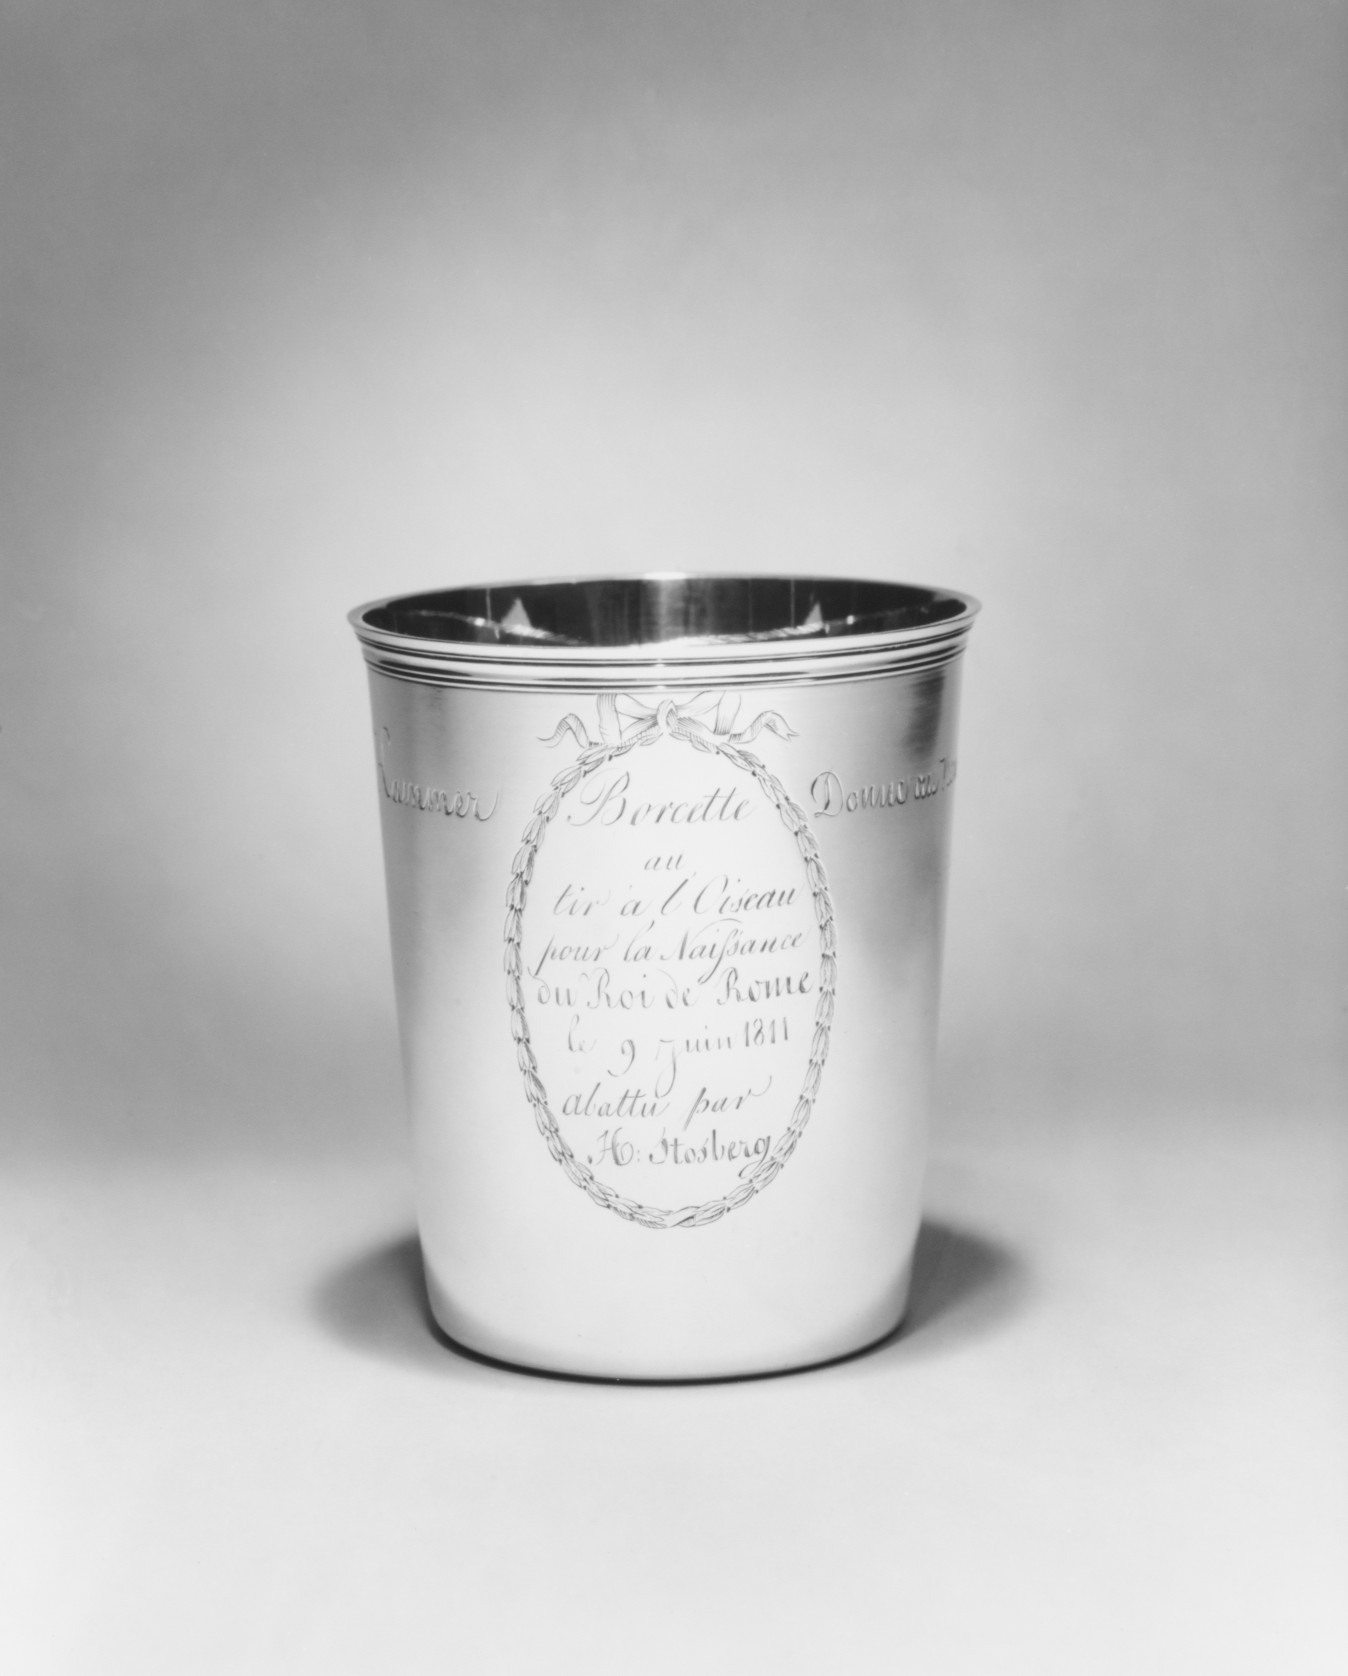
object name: beaker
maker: i.k.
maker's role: maker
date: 1811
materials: silver